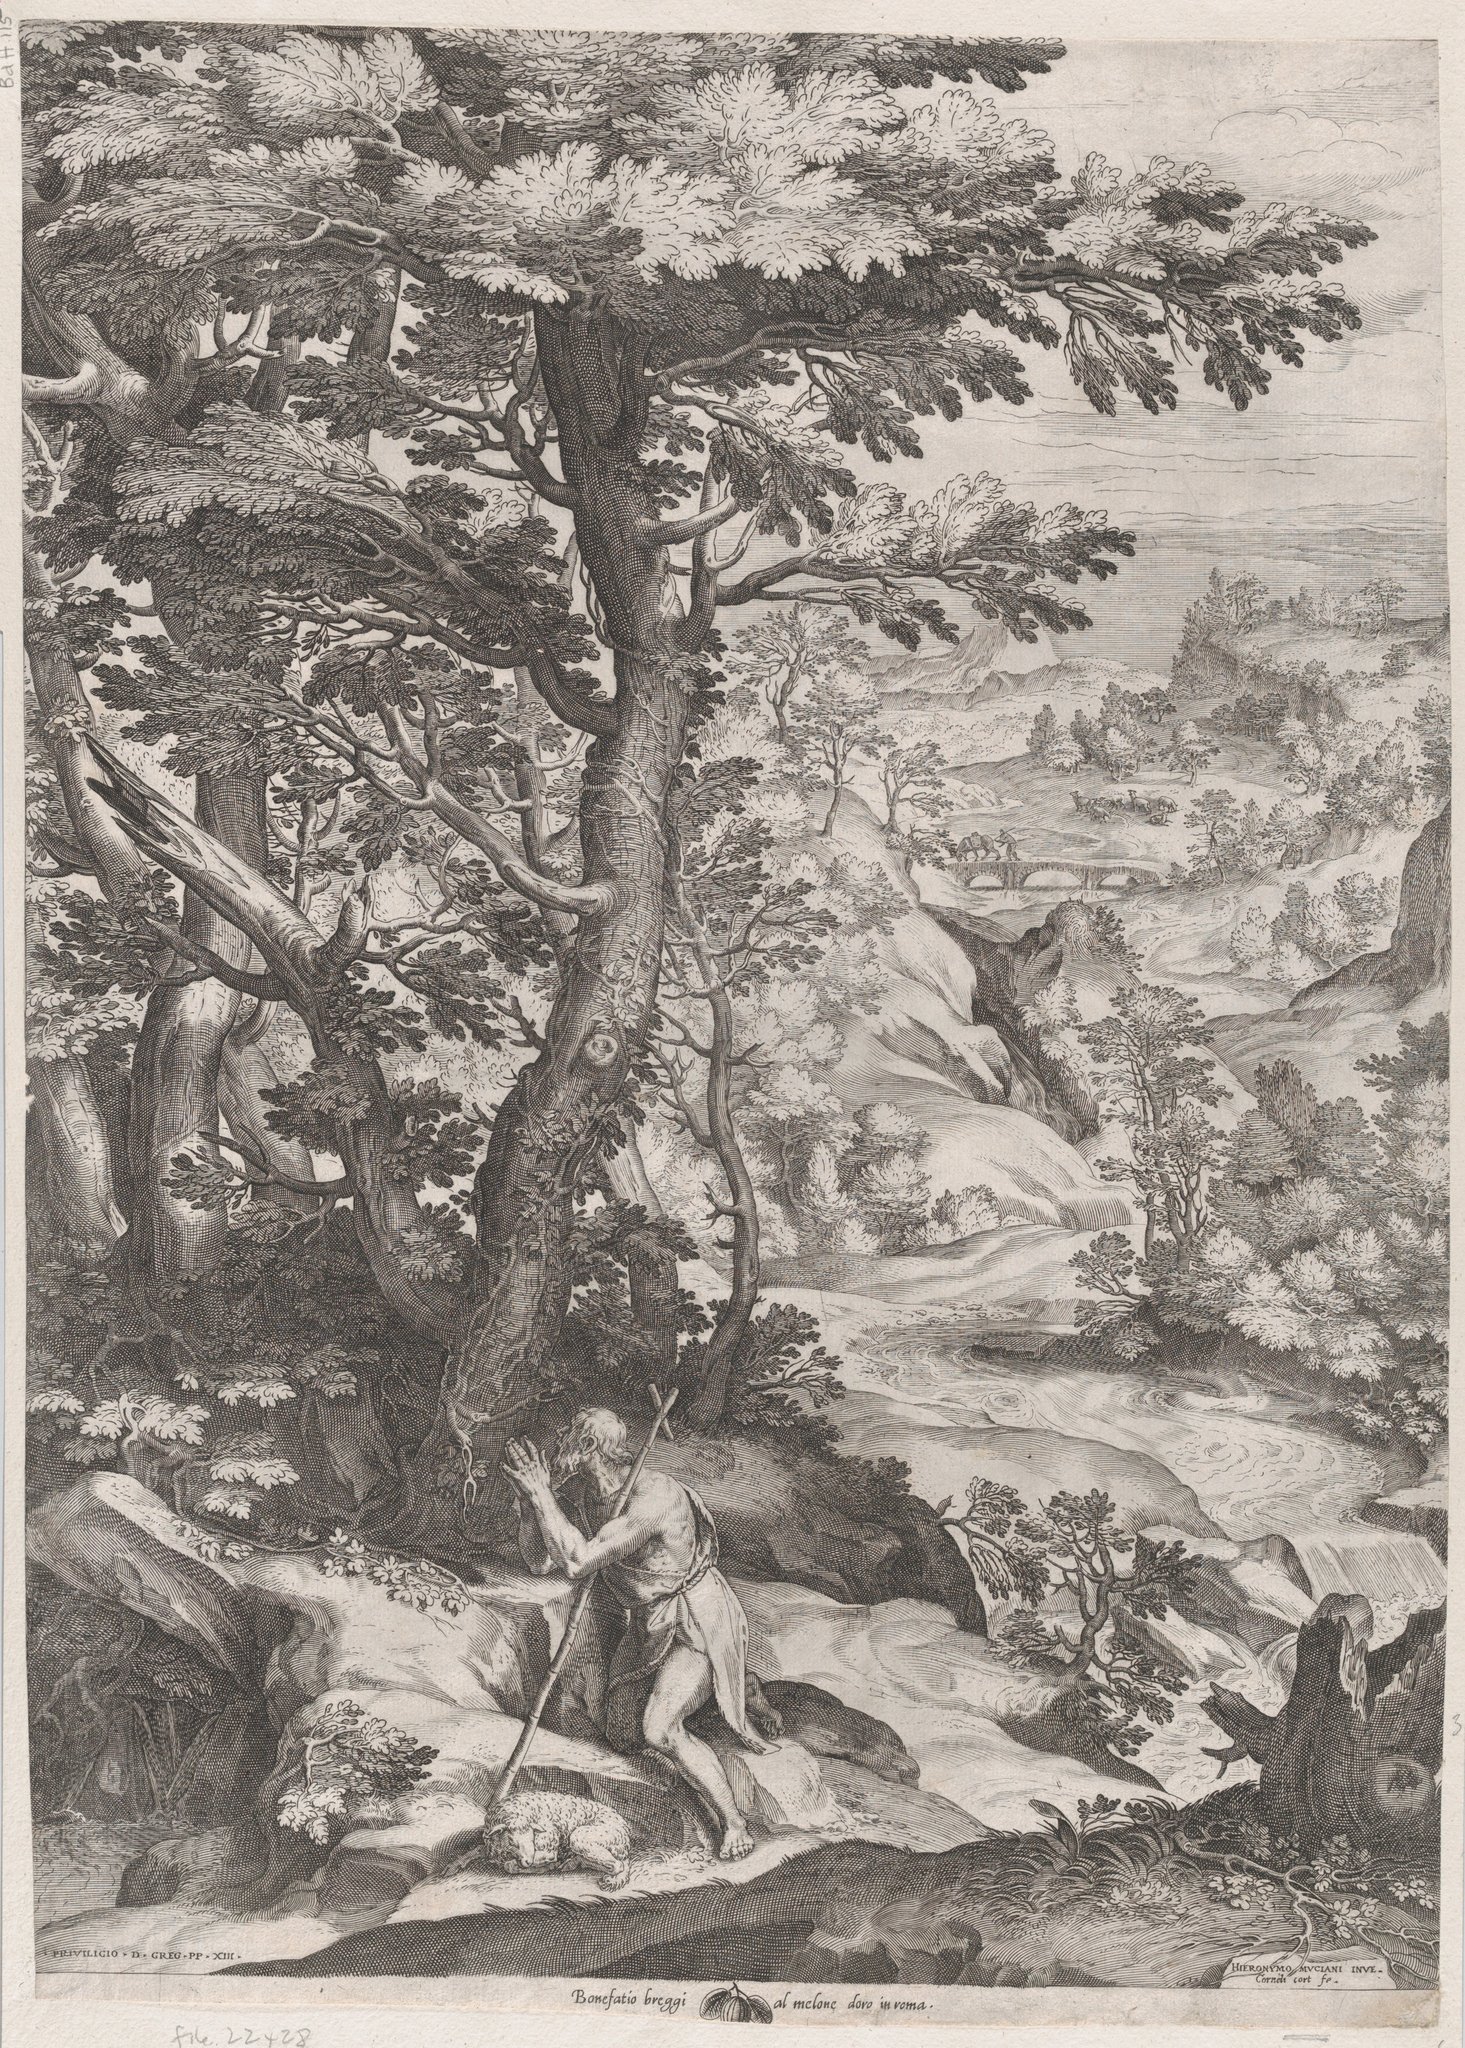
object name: print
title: St John the Baptist in the Wilderness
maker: cornelis cort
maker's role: artist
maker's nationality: netherlandish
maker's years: 1533-1578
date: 1533-1578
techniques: engraving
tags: trees,saint john the baptist